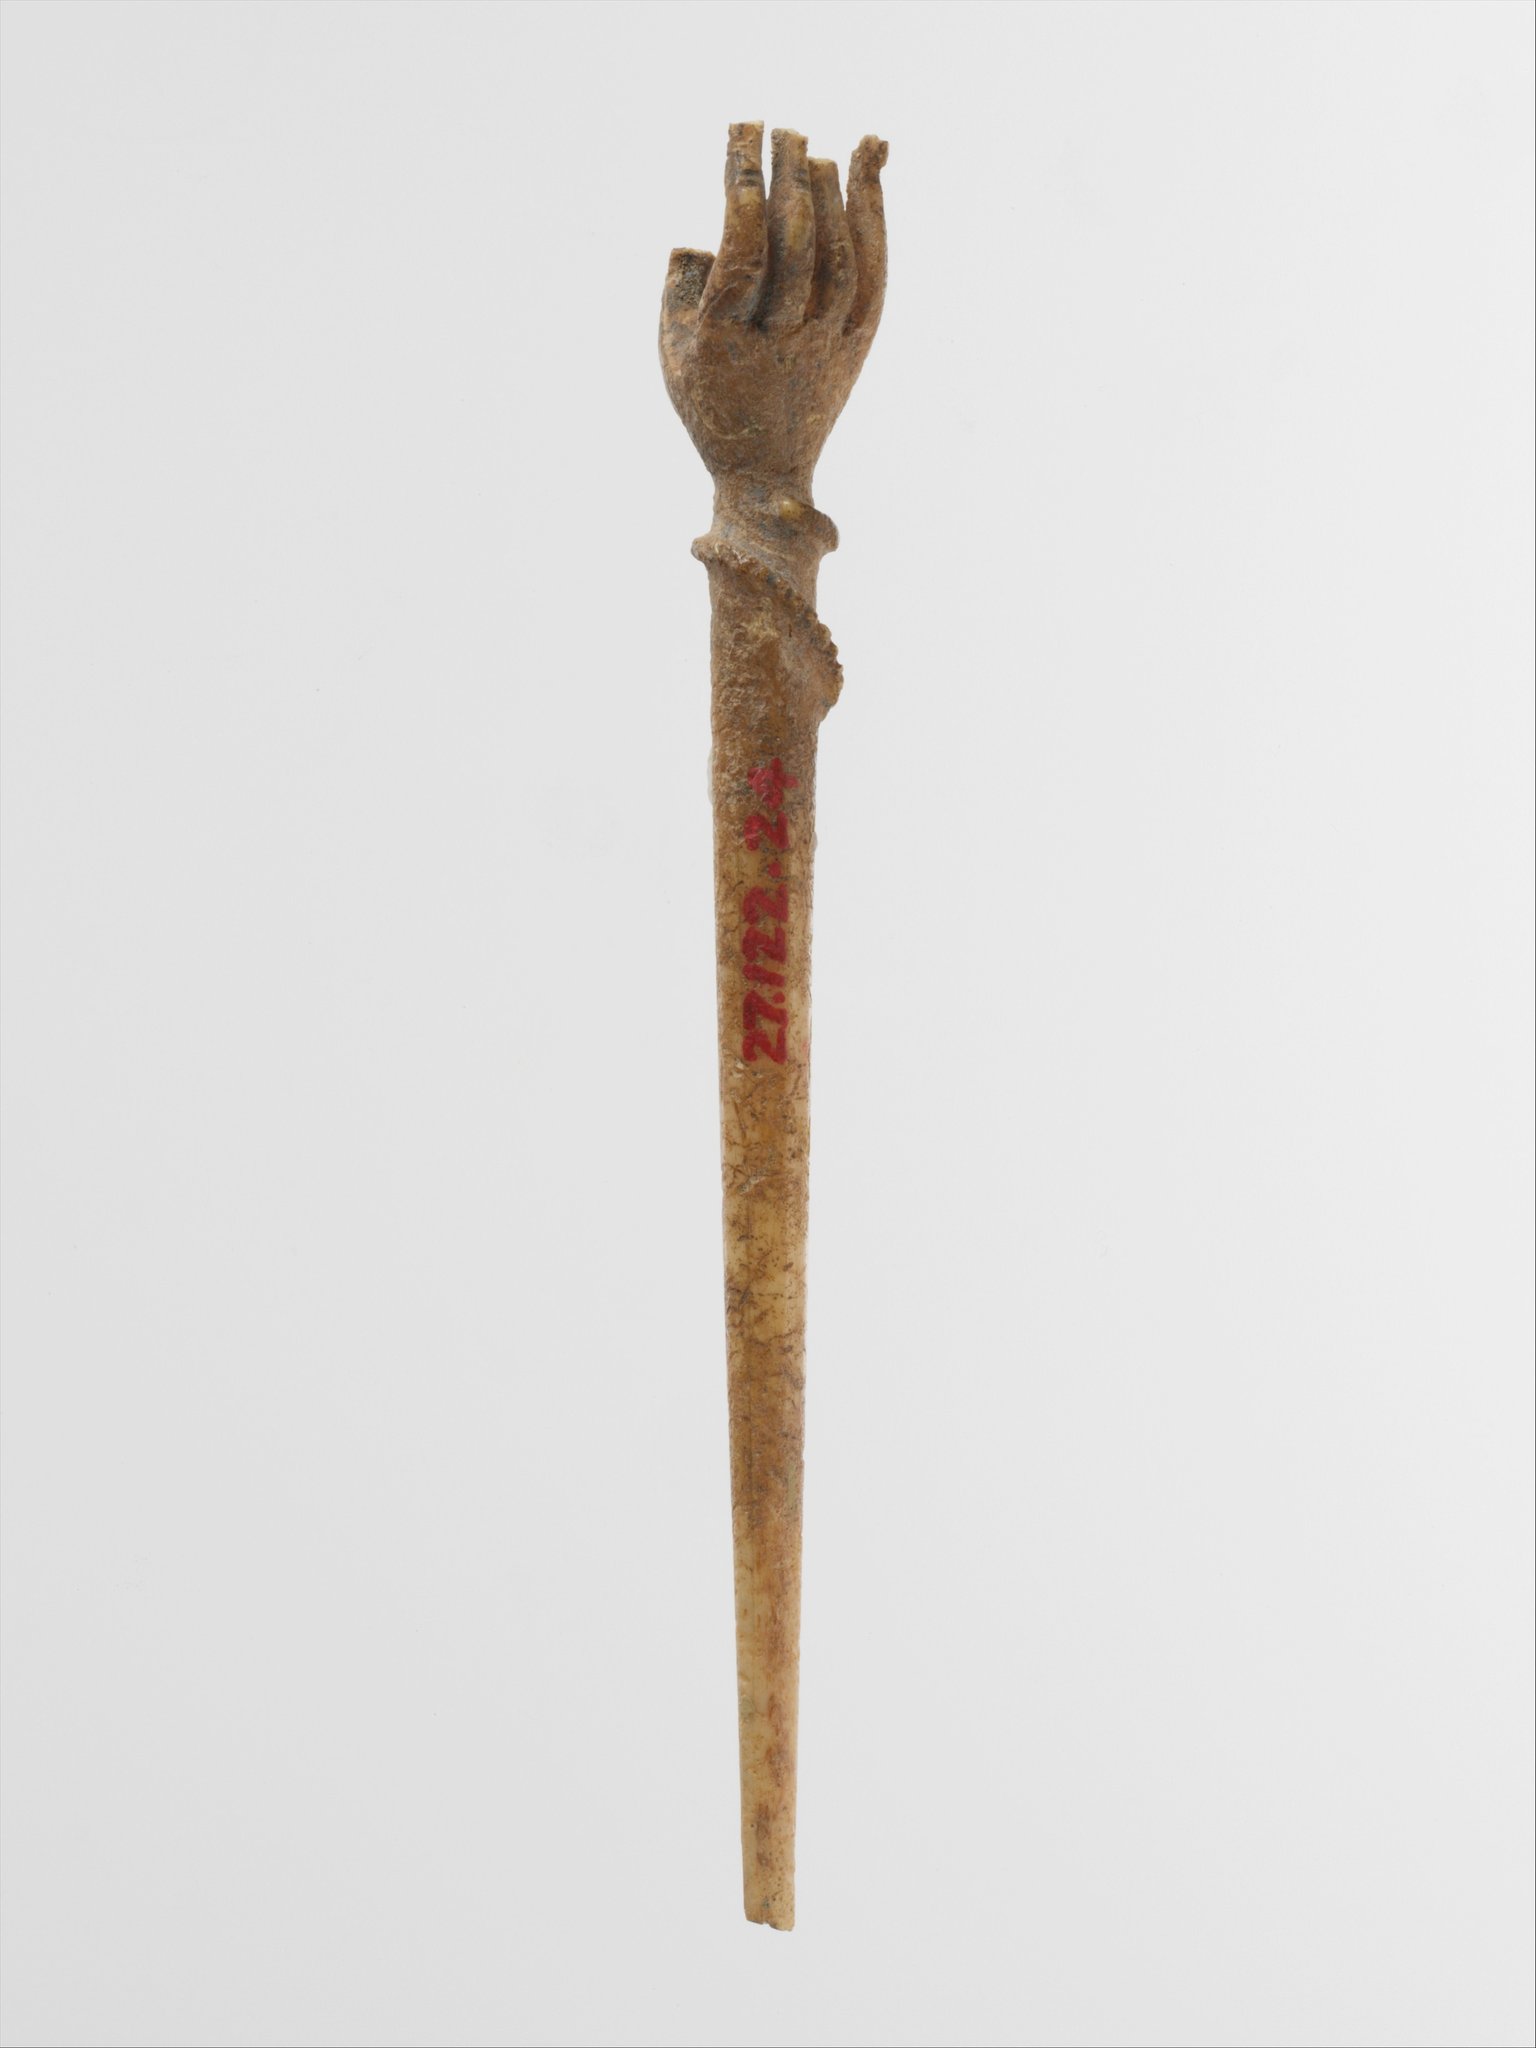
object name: pin with hand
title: Bone hairpin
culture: greek or roman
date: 1-100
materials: bone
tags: hands